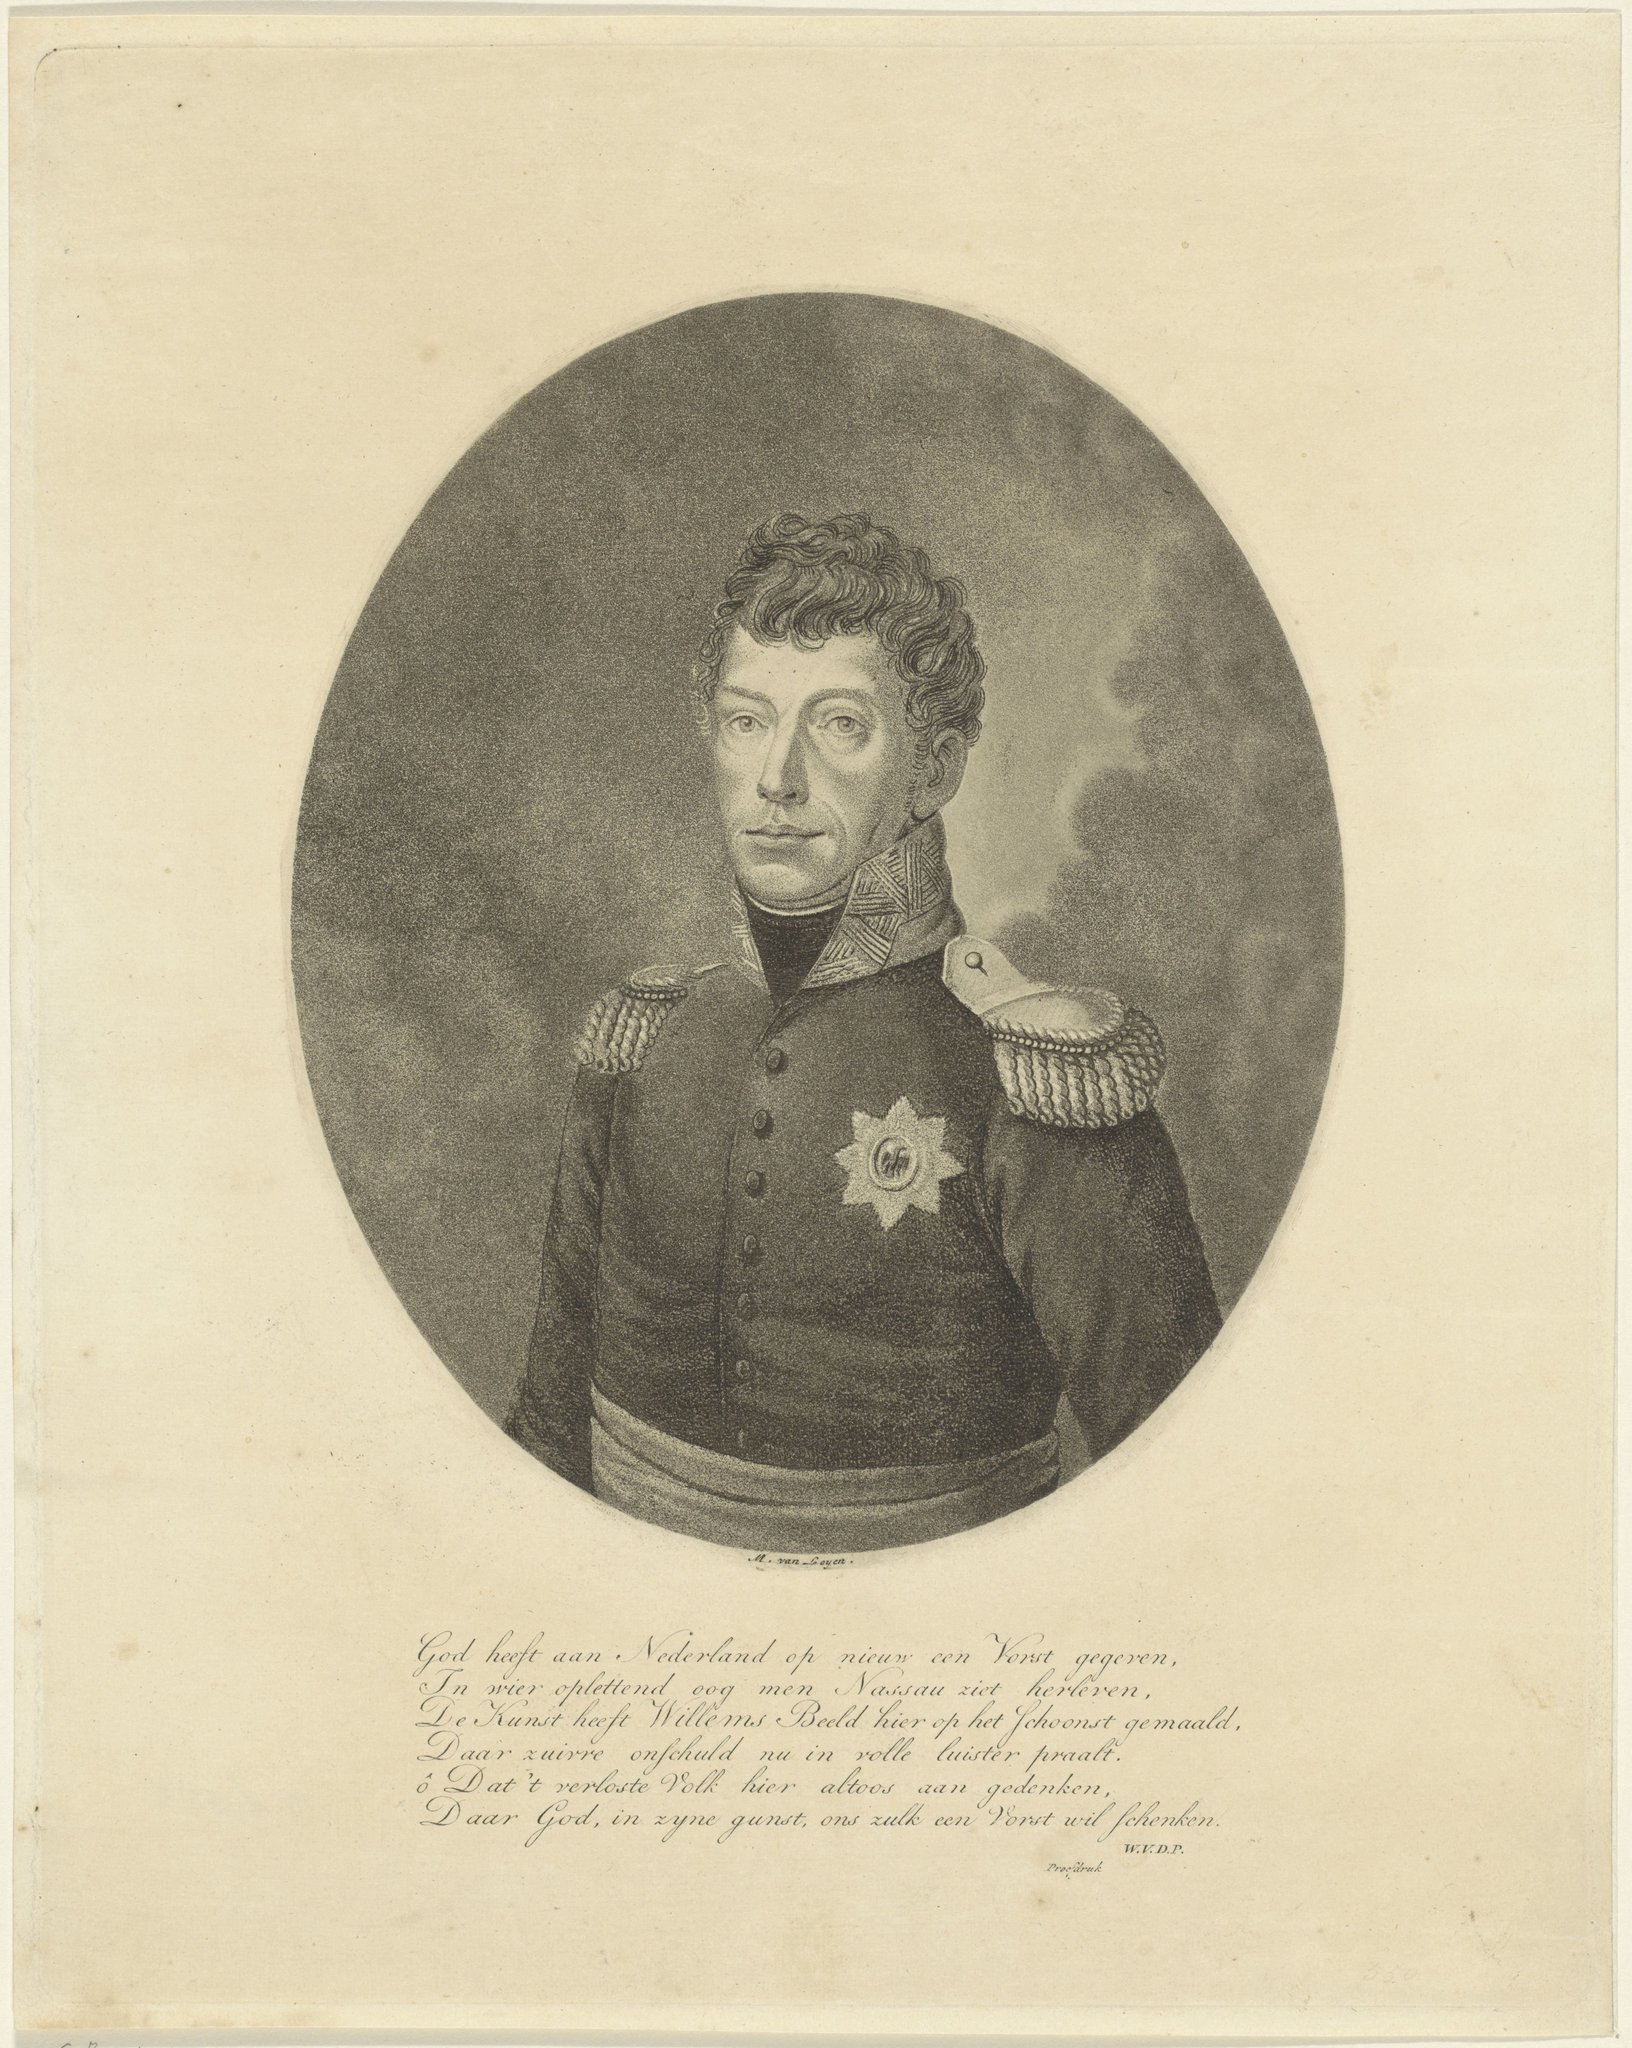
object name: print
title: Portret van Willem I Frederik, koning der Nederlanden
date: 1815-1899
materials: paper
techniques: aquatint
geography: amsterdam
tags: the hague, berlin, william i of the netherlands, knighthood order (with name) - insignia of a knighthood order, e.g.: badge, chain (with name of order)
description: De hier vermelde titel verwijst naar de hoogst verkregen titel van de geportretteerde, niet per se naar de titel die de geportretteerde op deze voorstelling draagt.